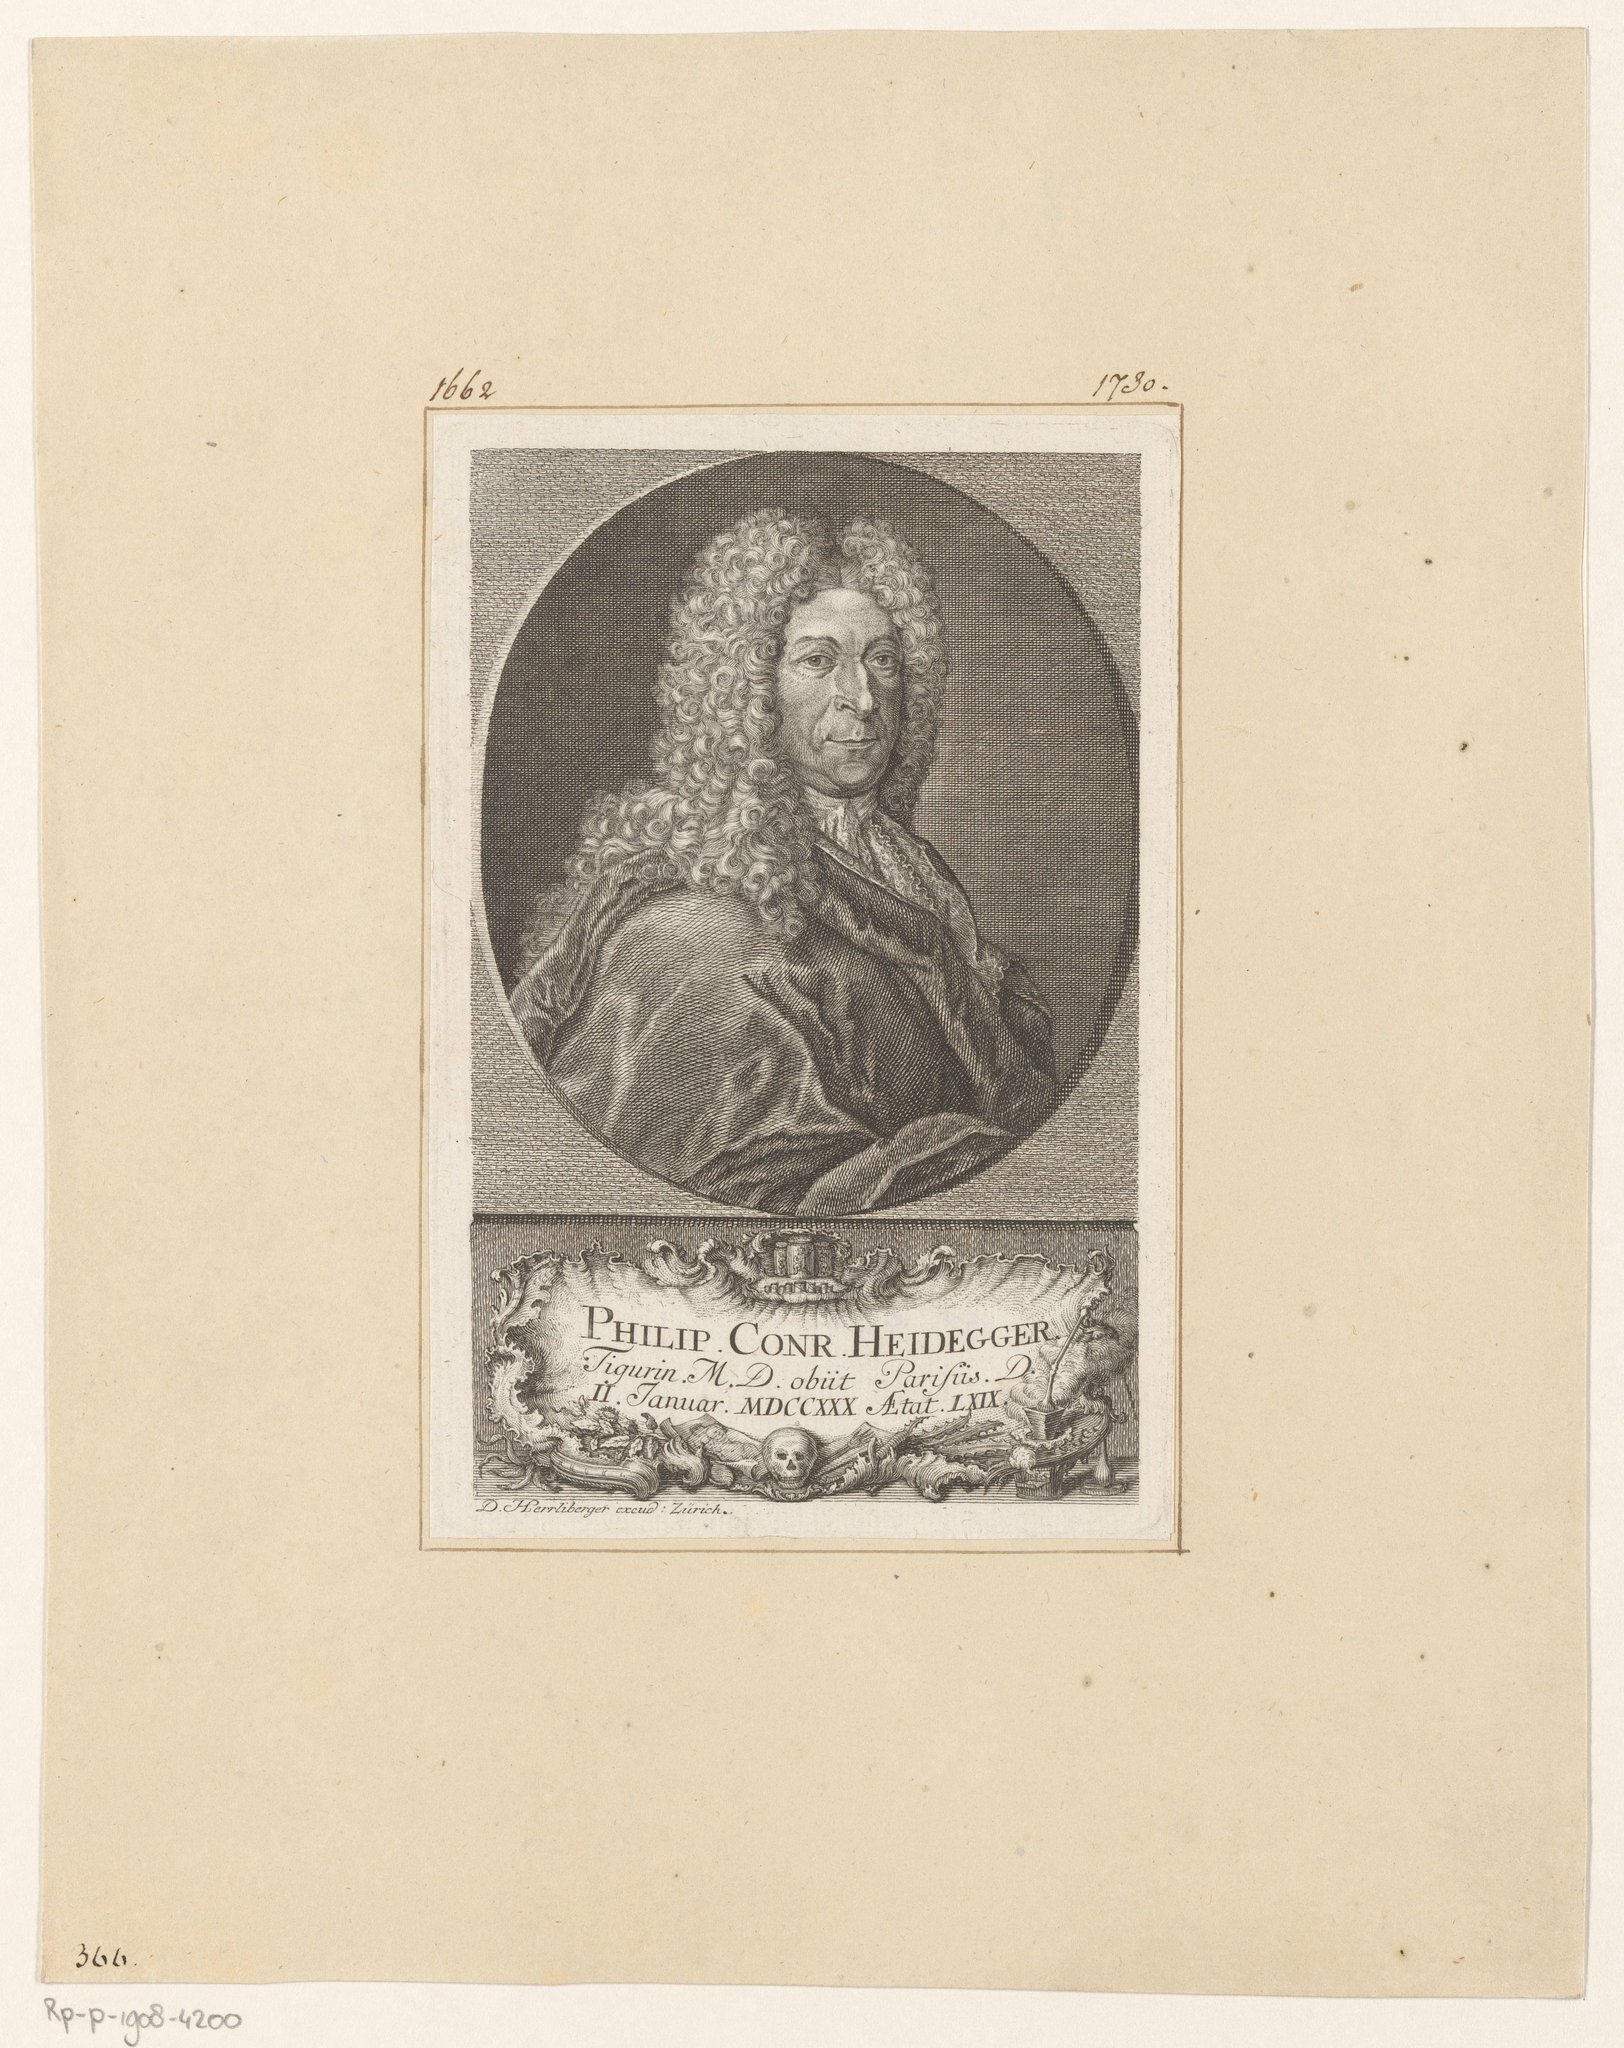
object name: print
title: Portret van Philipp Konrad Heidegger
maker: david herrliberger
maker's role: print maker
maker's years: 1697-1777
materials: paper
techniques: engraving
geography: zurich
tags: rocaille ornament, historical persons, symbols of death